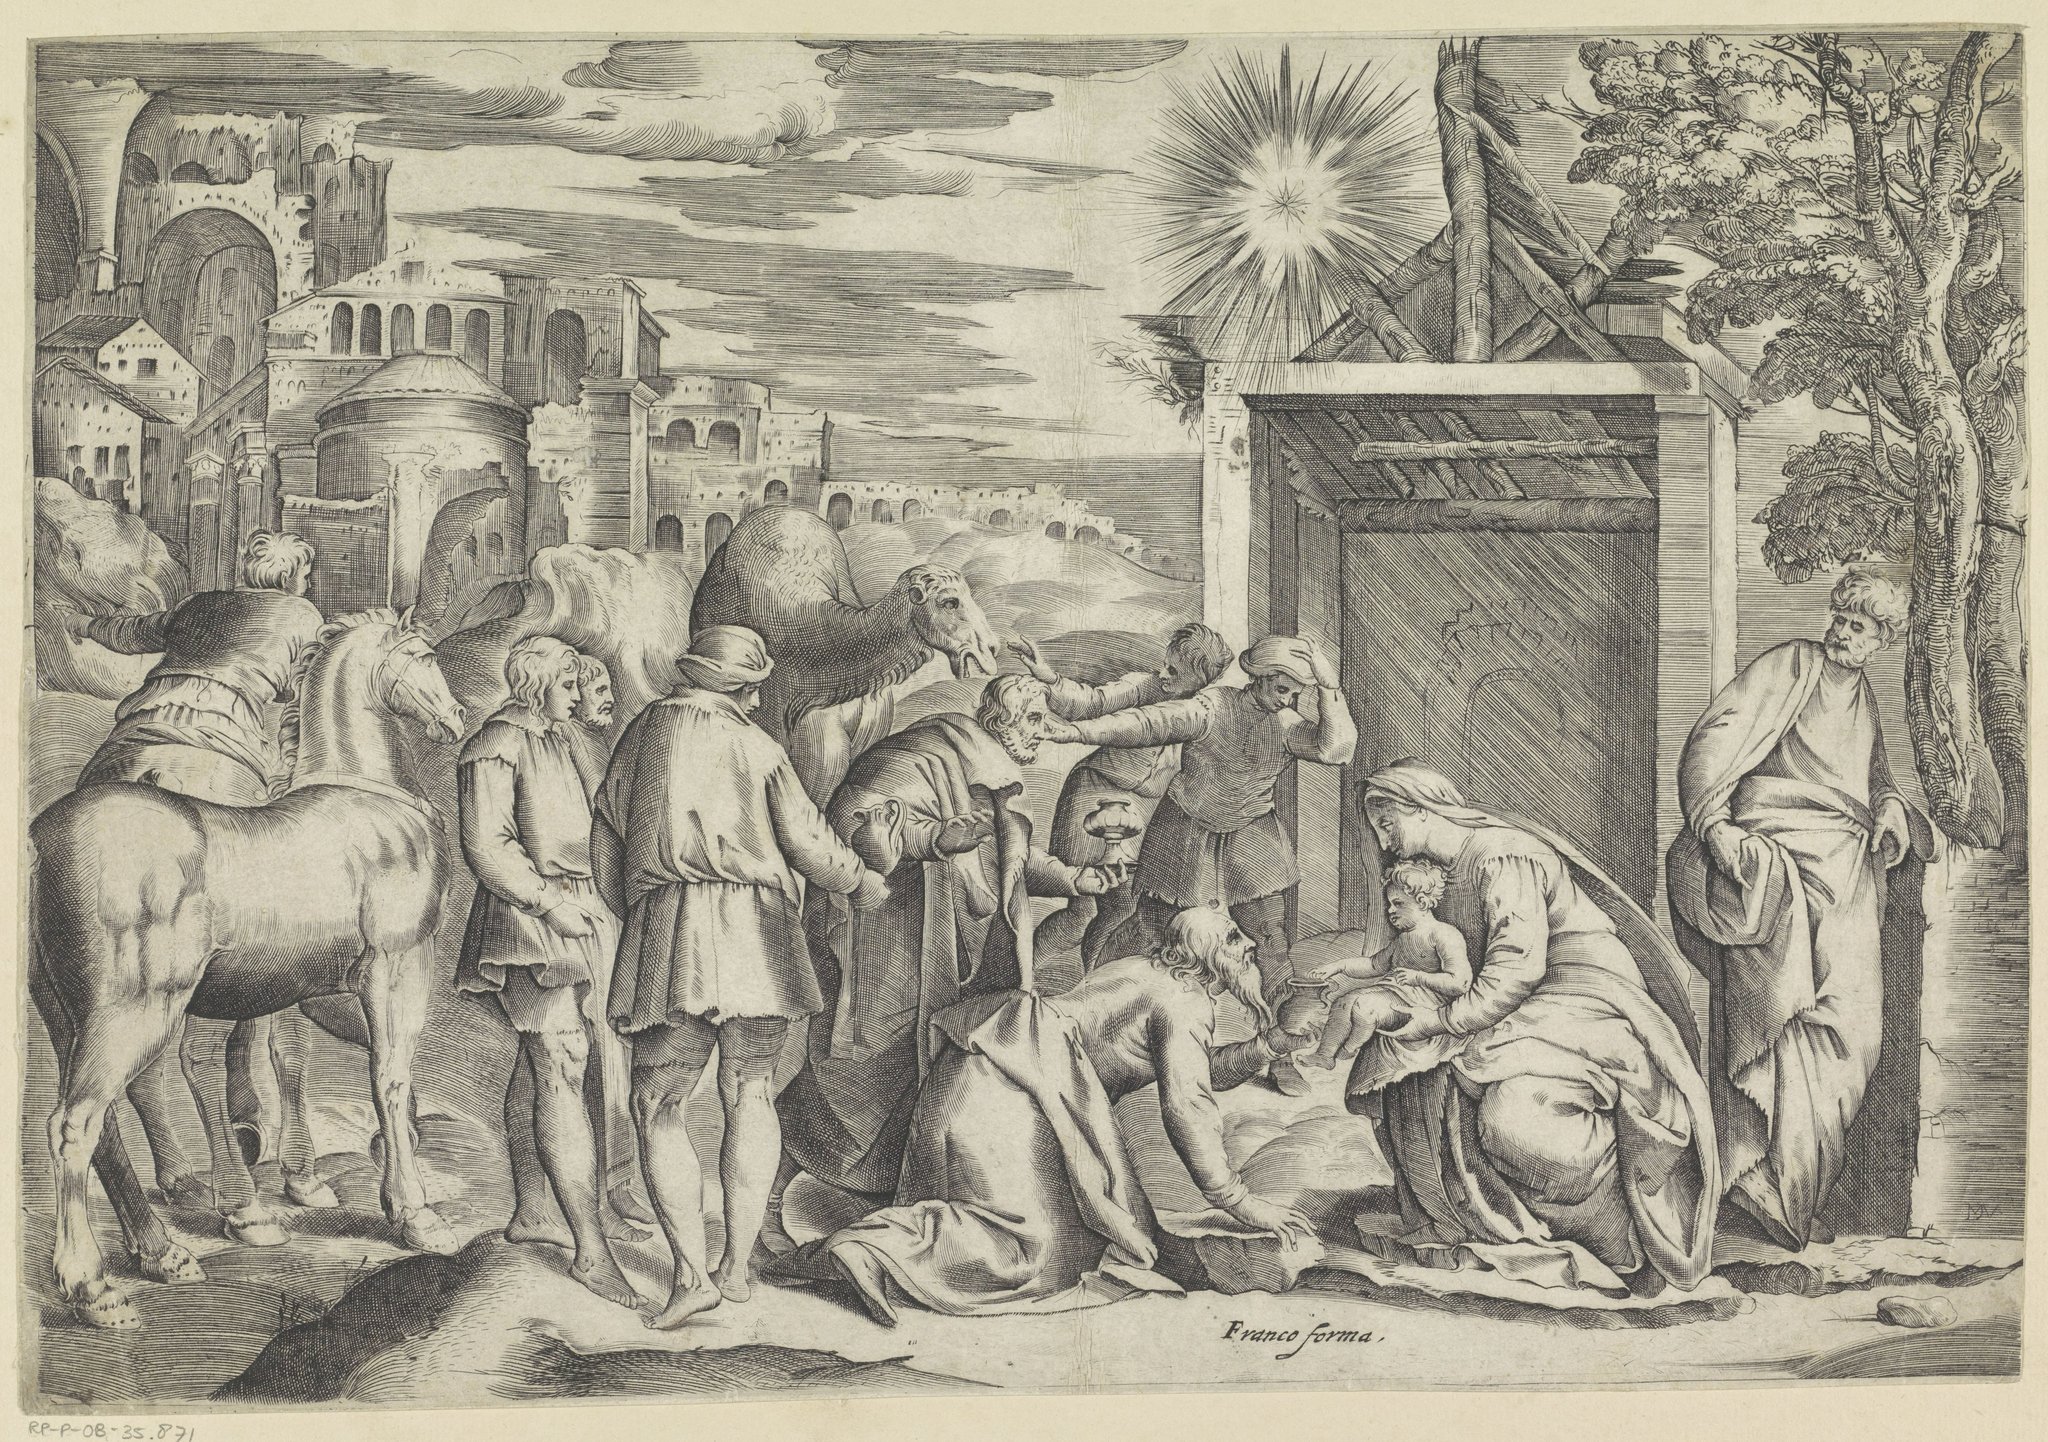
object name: print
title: Aanbidding door de koningen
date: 1508-1561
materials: paper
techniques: engraving, etching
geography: italy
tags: hoofed animals: camel, adoration of the kings: the wise men present their gifts to the christ-child (gold, frankincense and myrrh), horse, landscape with ruins - ii - ideal landscapes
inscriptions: collector's mark: Lugt 240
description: De drie koningen aanbidden het Christuskind dat op schoot zit bij Maria. Achter hen staan mannen uit hun gevolg met kamelen en paarden. Achter Maria staat Jozef. Op de achtergrond ruïnes van antieke bouwwerken.